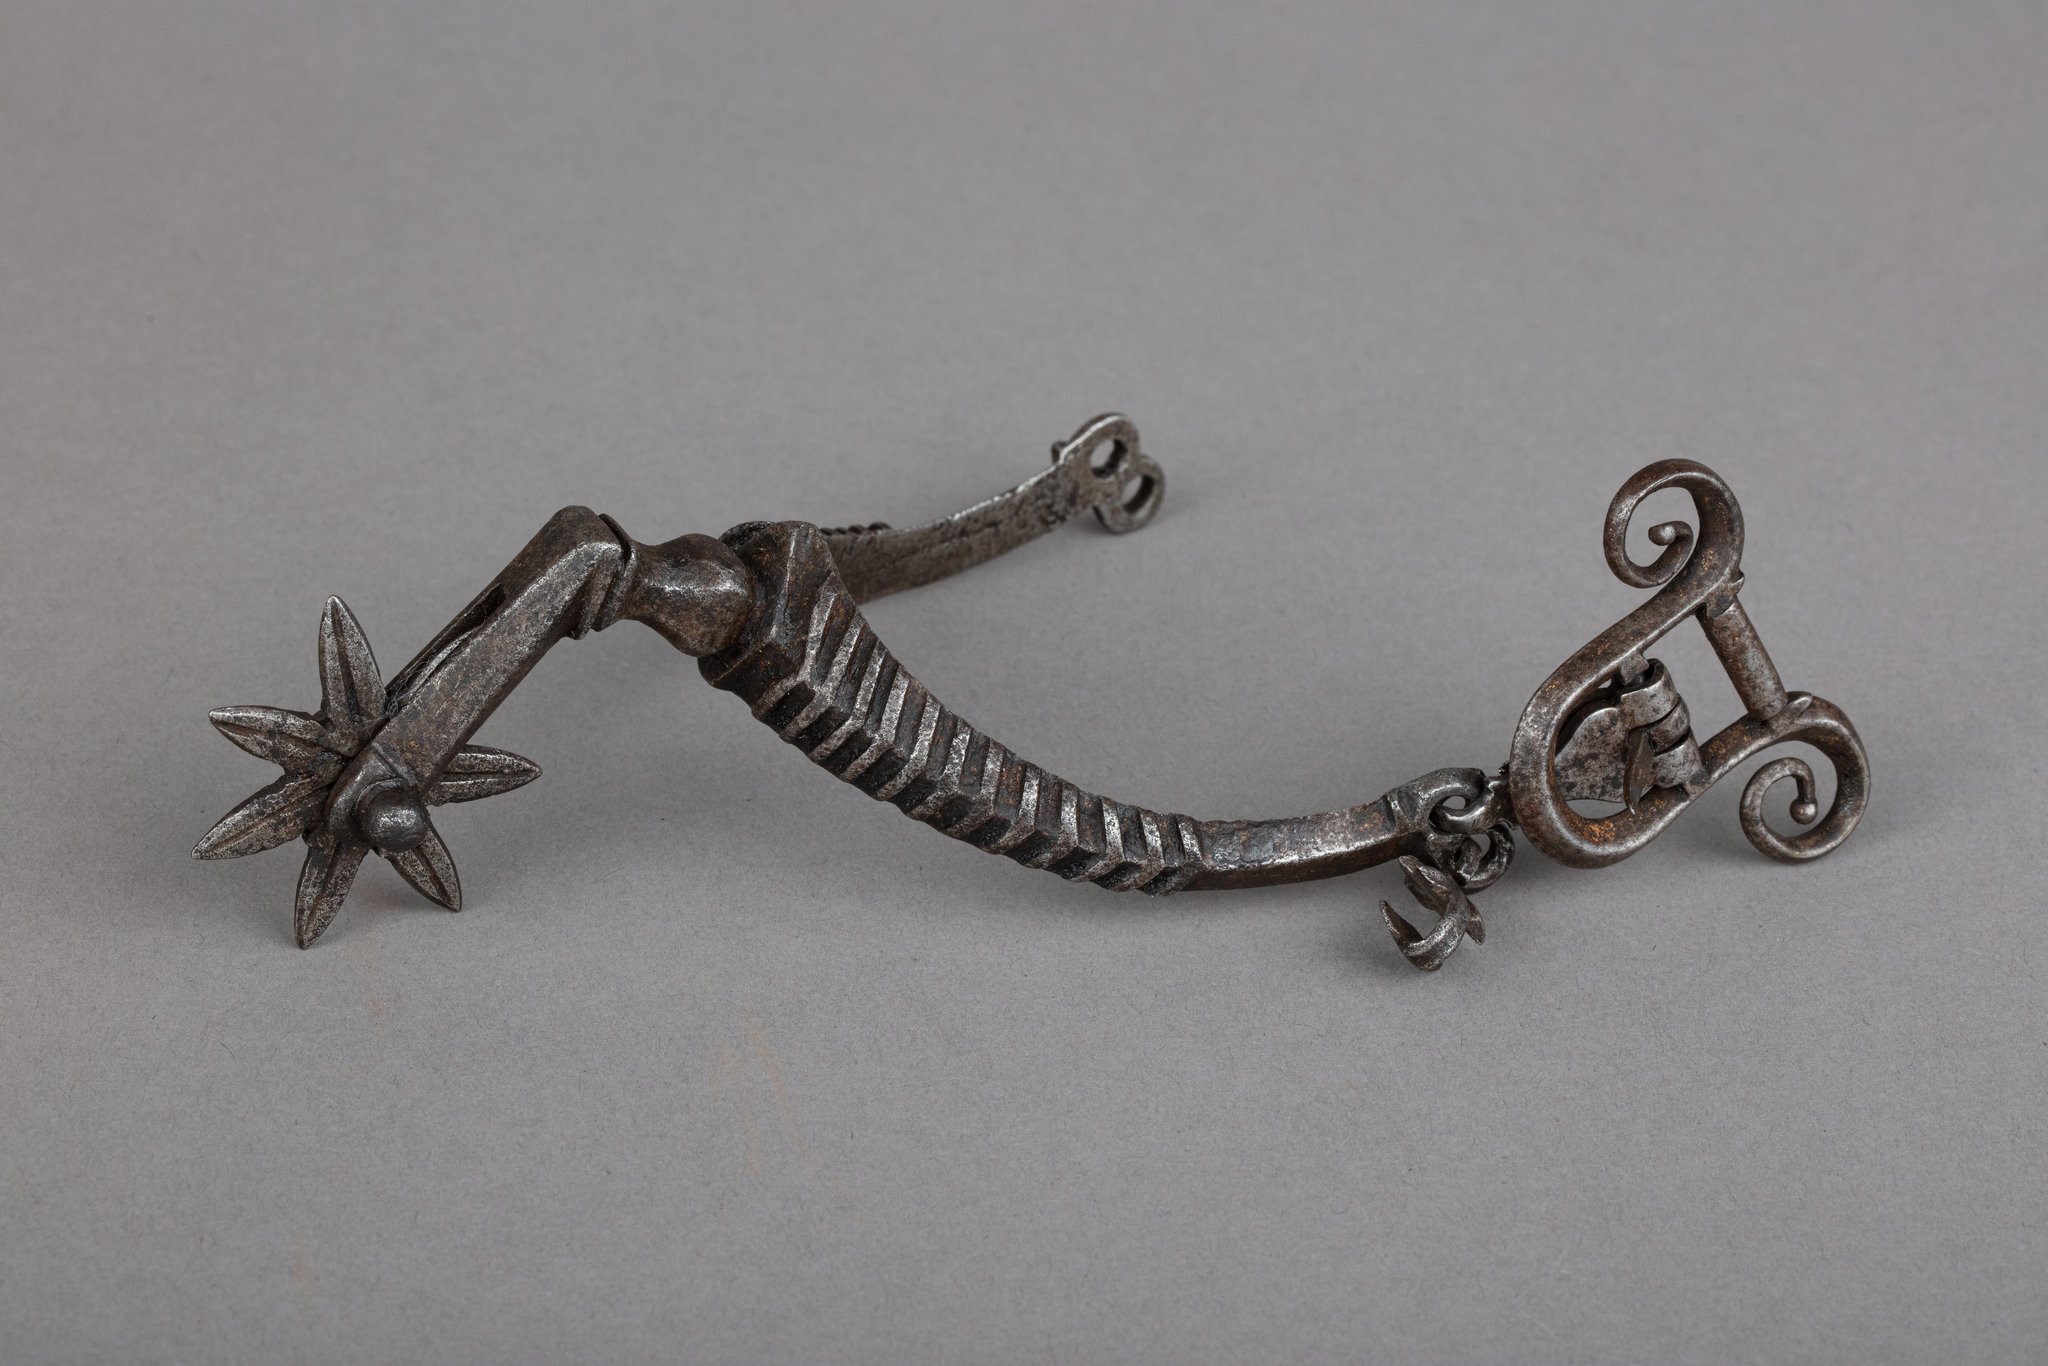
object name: spur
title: Rowel Spur (Right)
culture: dutch or german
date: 1634-1666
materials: gold, metal alloy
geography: netherlands